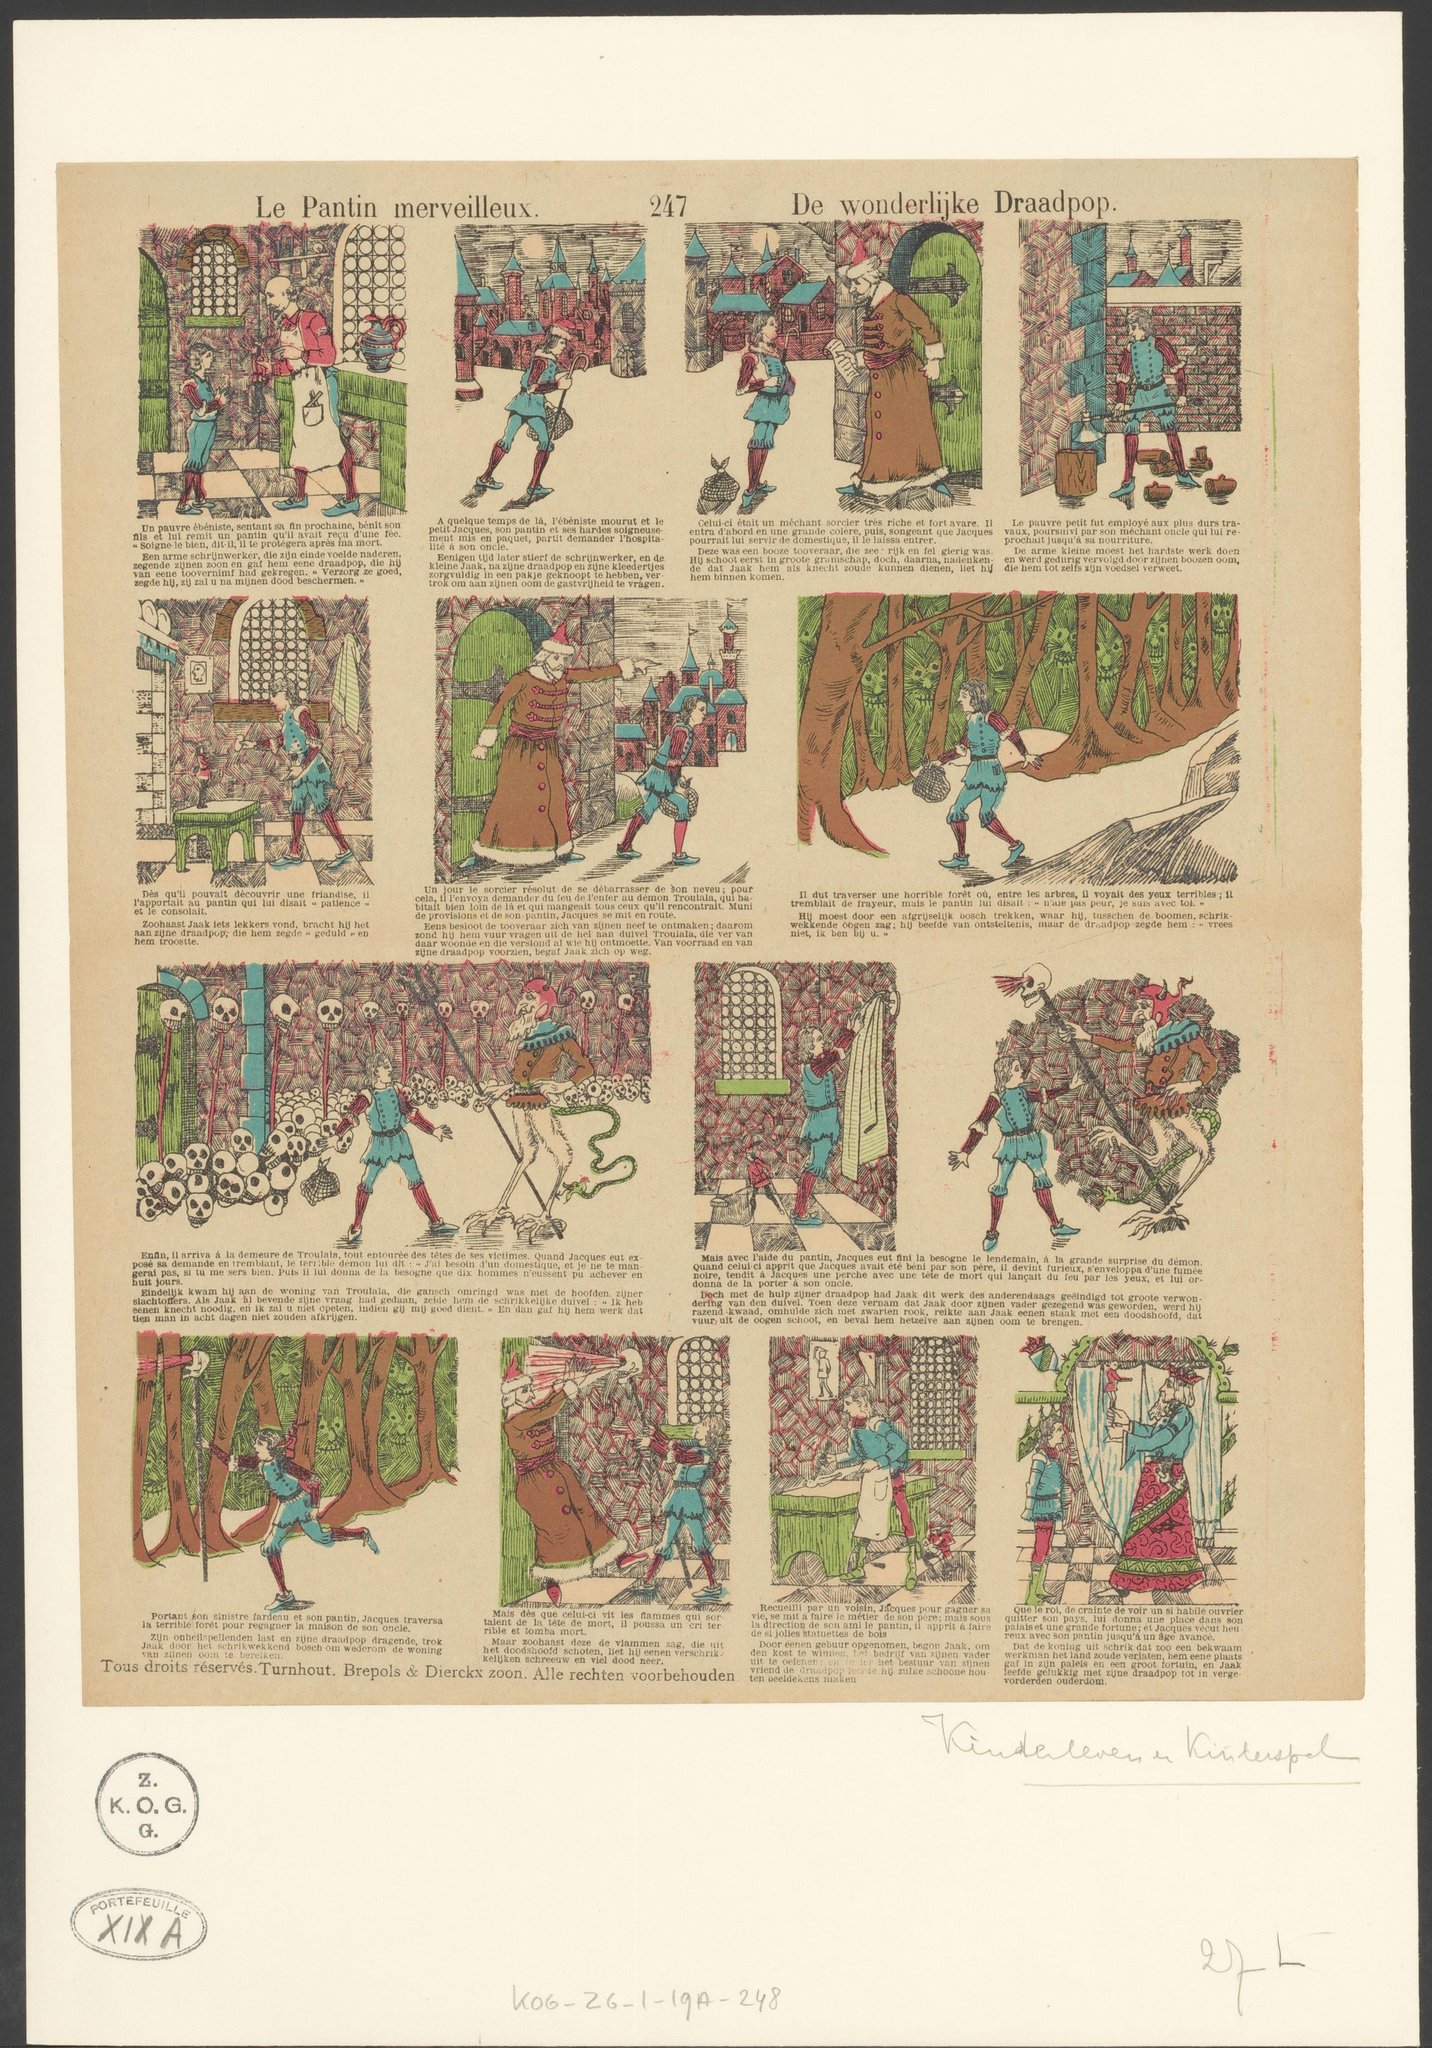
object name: print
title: Wonderlijke draadpop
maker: Anonymous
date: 1833-1911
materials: paper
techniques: lithograph, letterpress printing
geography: turnhout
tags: magic, supernaturalism, occultism, (playing with) dolls, tales and fairy tales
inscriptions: collector's mark: Lugt 1641, stamp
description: Blad met veertien voorstellingen uit het verhaal van de wonderlijke draadpop. Onder elke afbeelding een onderschrift in het Nederlands en in het Frans. Genummerd midden boven: 247. Onderwerpsrubrieken binnen de Atlas Zeden en Gewoonten: Zeden en Gewoonten in Engeren Zin, Des menschen beging, midden en einde, Kinderleven – Kinderspel en Kinderprenten.